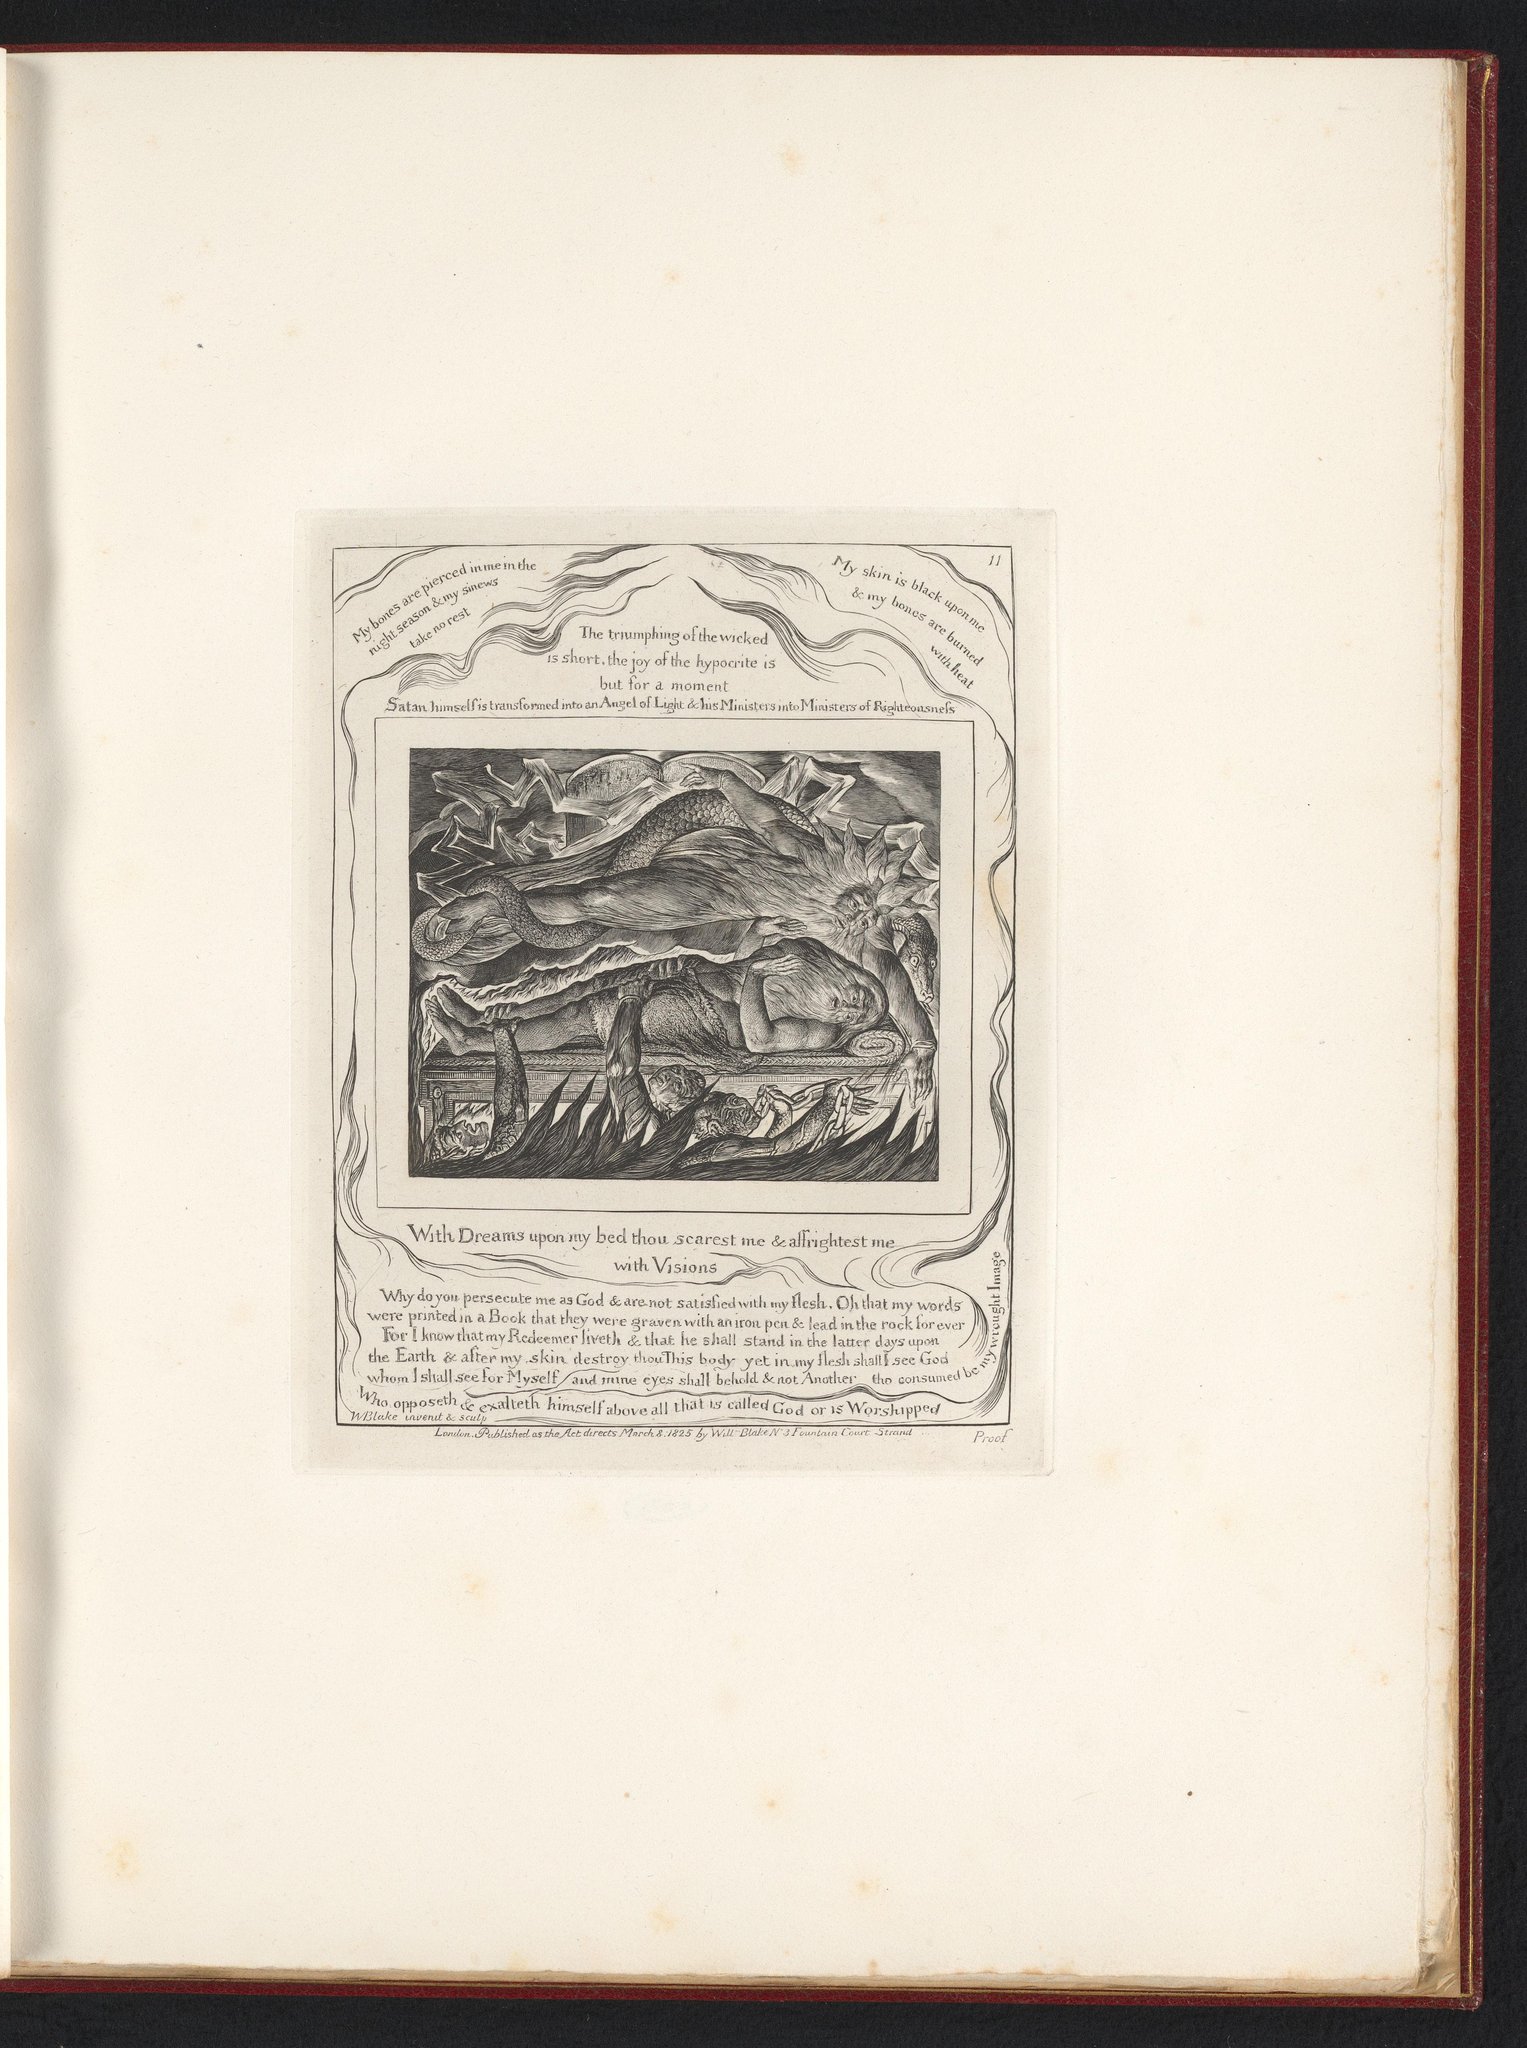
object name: print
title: Job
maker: william blake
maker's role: print maker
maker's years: 1757-1827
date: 1825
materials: paper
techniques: engraving, etching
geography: london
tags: job on the dunghill with satan (or devils) abusing and tormenting him; job's wife may be present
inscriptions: collector's mark: Lugt 2228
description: Prent maakt deel uit van een serie van 21 prenten. Er bestaan 150 afdrukken van de serie met daarop 'proof'.